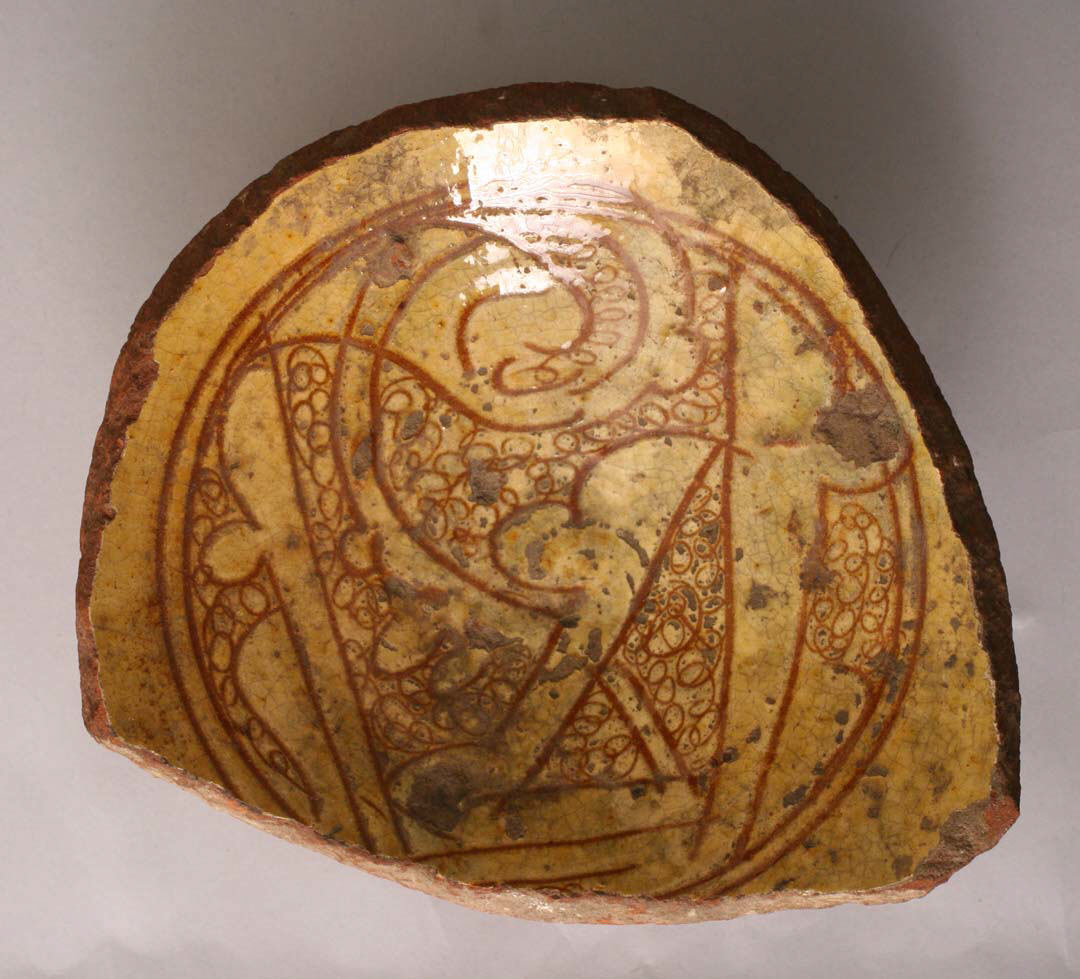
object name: fragment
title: Fragment of a Bowl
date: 1301-1500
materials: earthenware, glaze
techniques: coloring, incising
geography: egypt